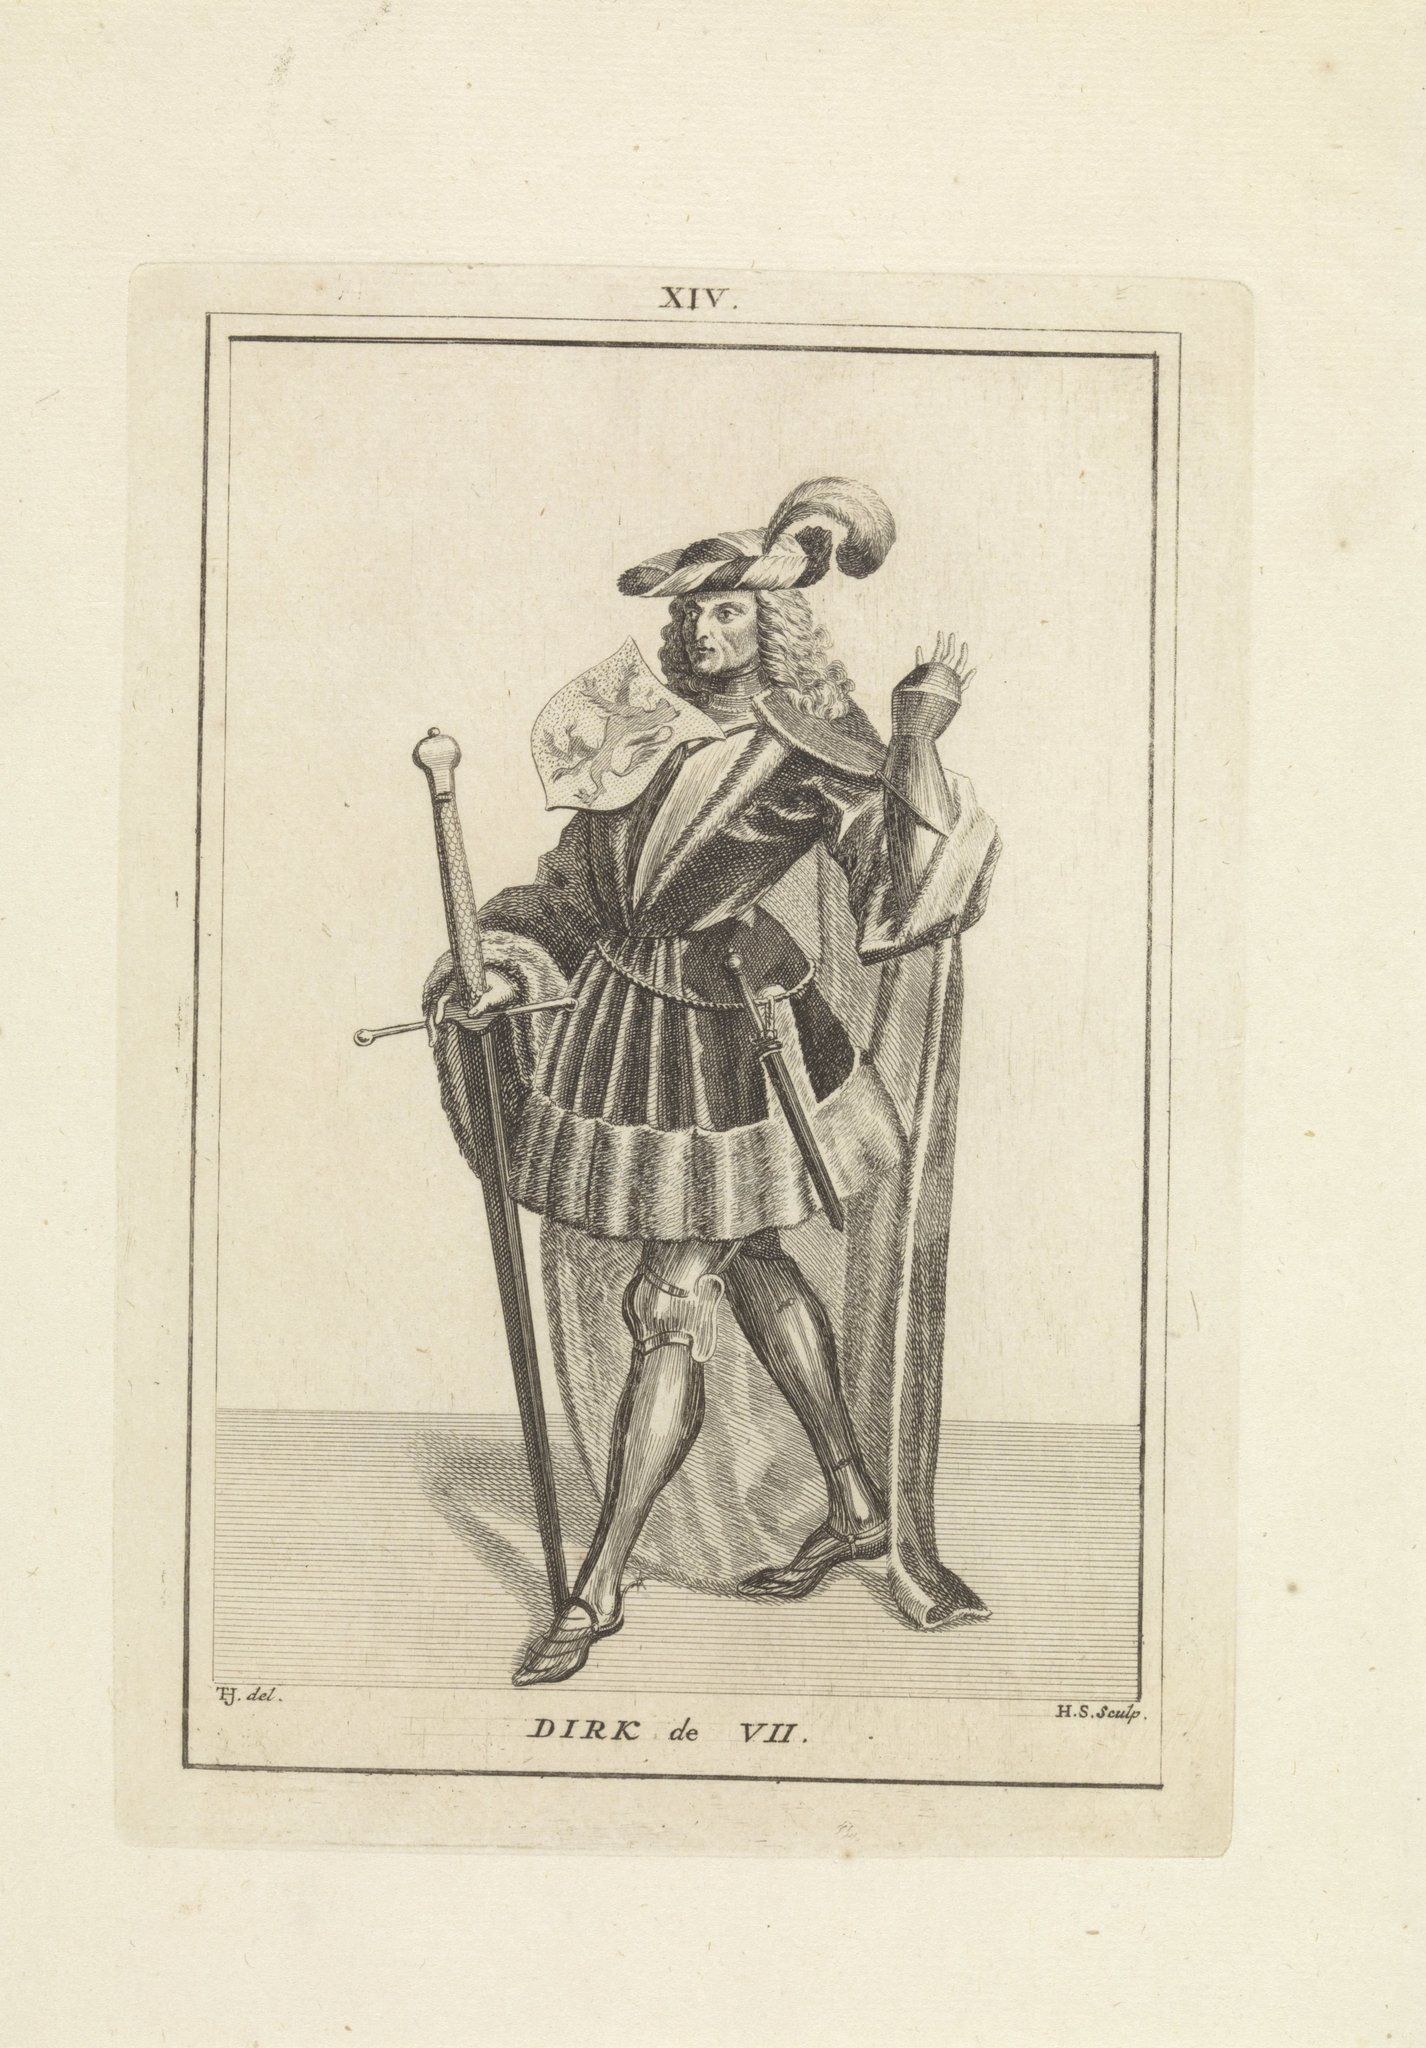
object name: book illustration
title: Portret van Dirk VII, graaf van Holland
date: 1745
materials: paper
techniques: etching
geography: haarlem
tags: dordrecht, nobility and patriciate; chivalry, knighthood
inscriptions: collector's mark: Lugt 2228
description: Boekillustratie voor: Langendyk, Pieter. De Graaven van Holland, in jaardichten beschreven door Pieter Langendyk. Verykt met alle de beeldtenissen dier prinsen, naauwkeurig getekend naar de echte aloude tafereelen of de zaal van't raadhuis der stad Haarlem. Haarlem: J. Bosch, 1745.